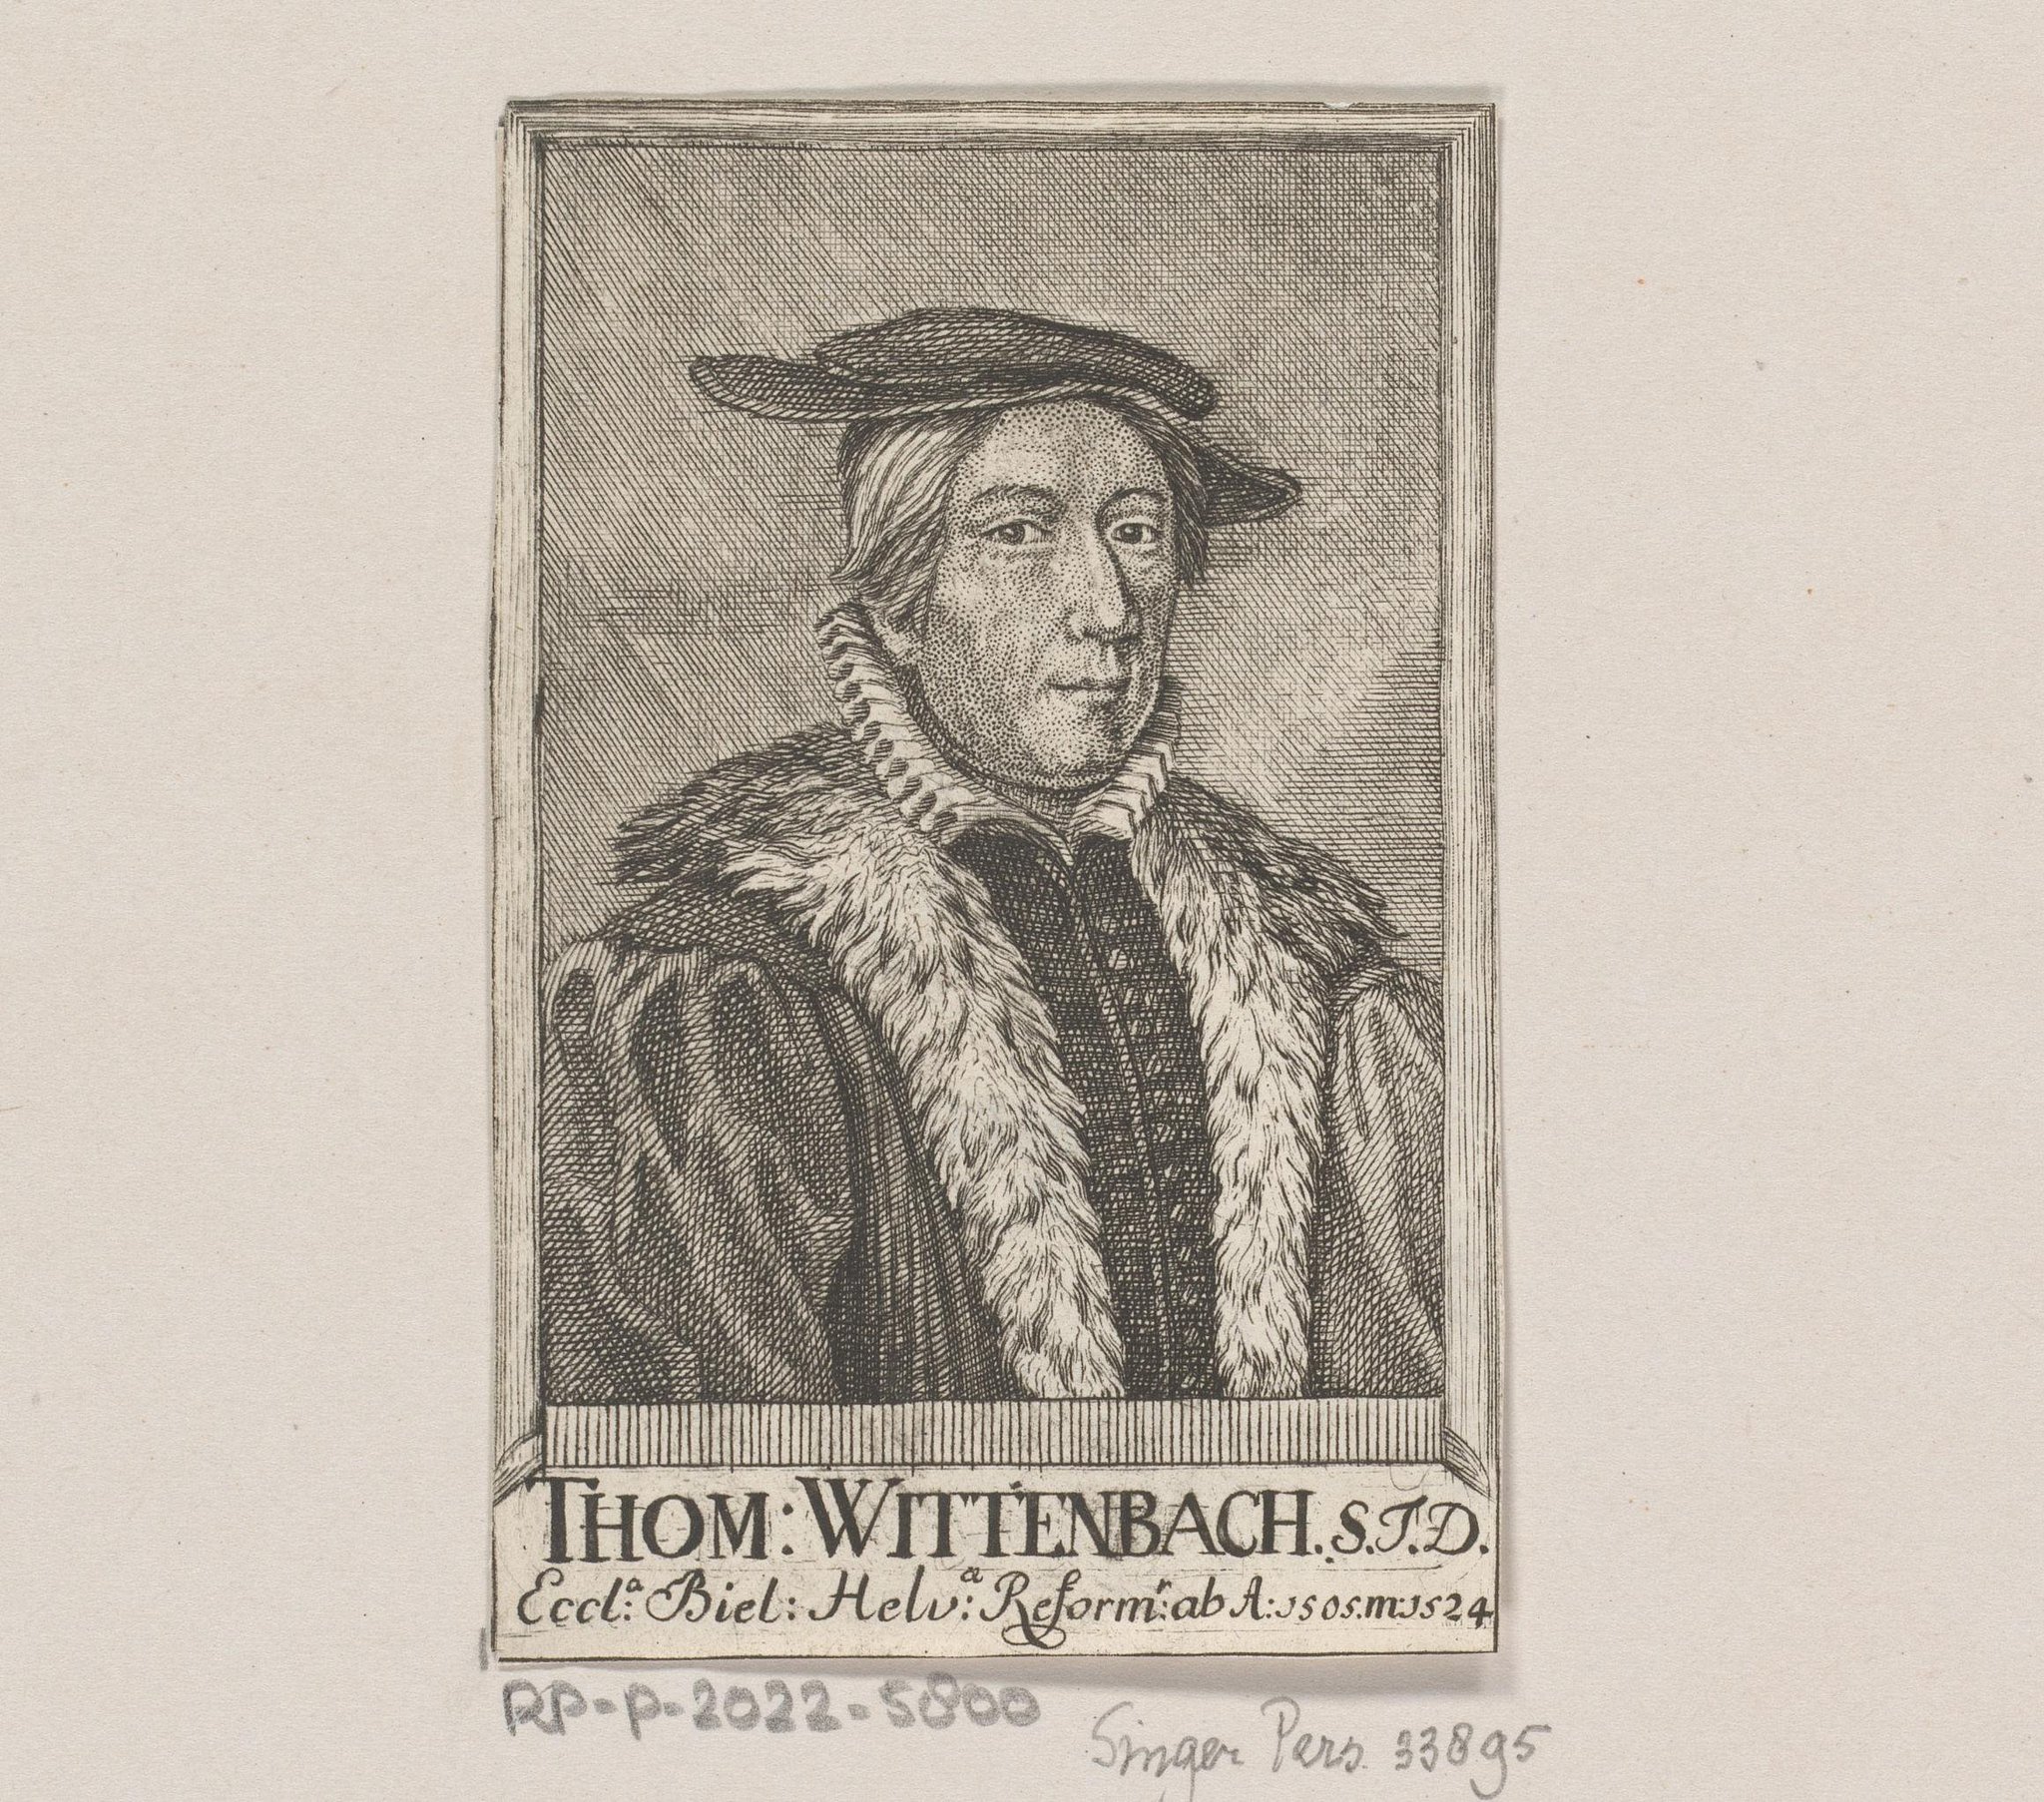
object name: book illustration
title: Portret van Thomas Wyttenbach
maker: Anonymous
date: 1742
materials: paper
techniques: etching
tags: historical persons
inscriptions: collector's mark: Lugt 2166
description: Prent waarschijnlijk uit: Bernerisches Mausoleum (…). Bern: Jeanne Esther Bondeli, 1742.